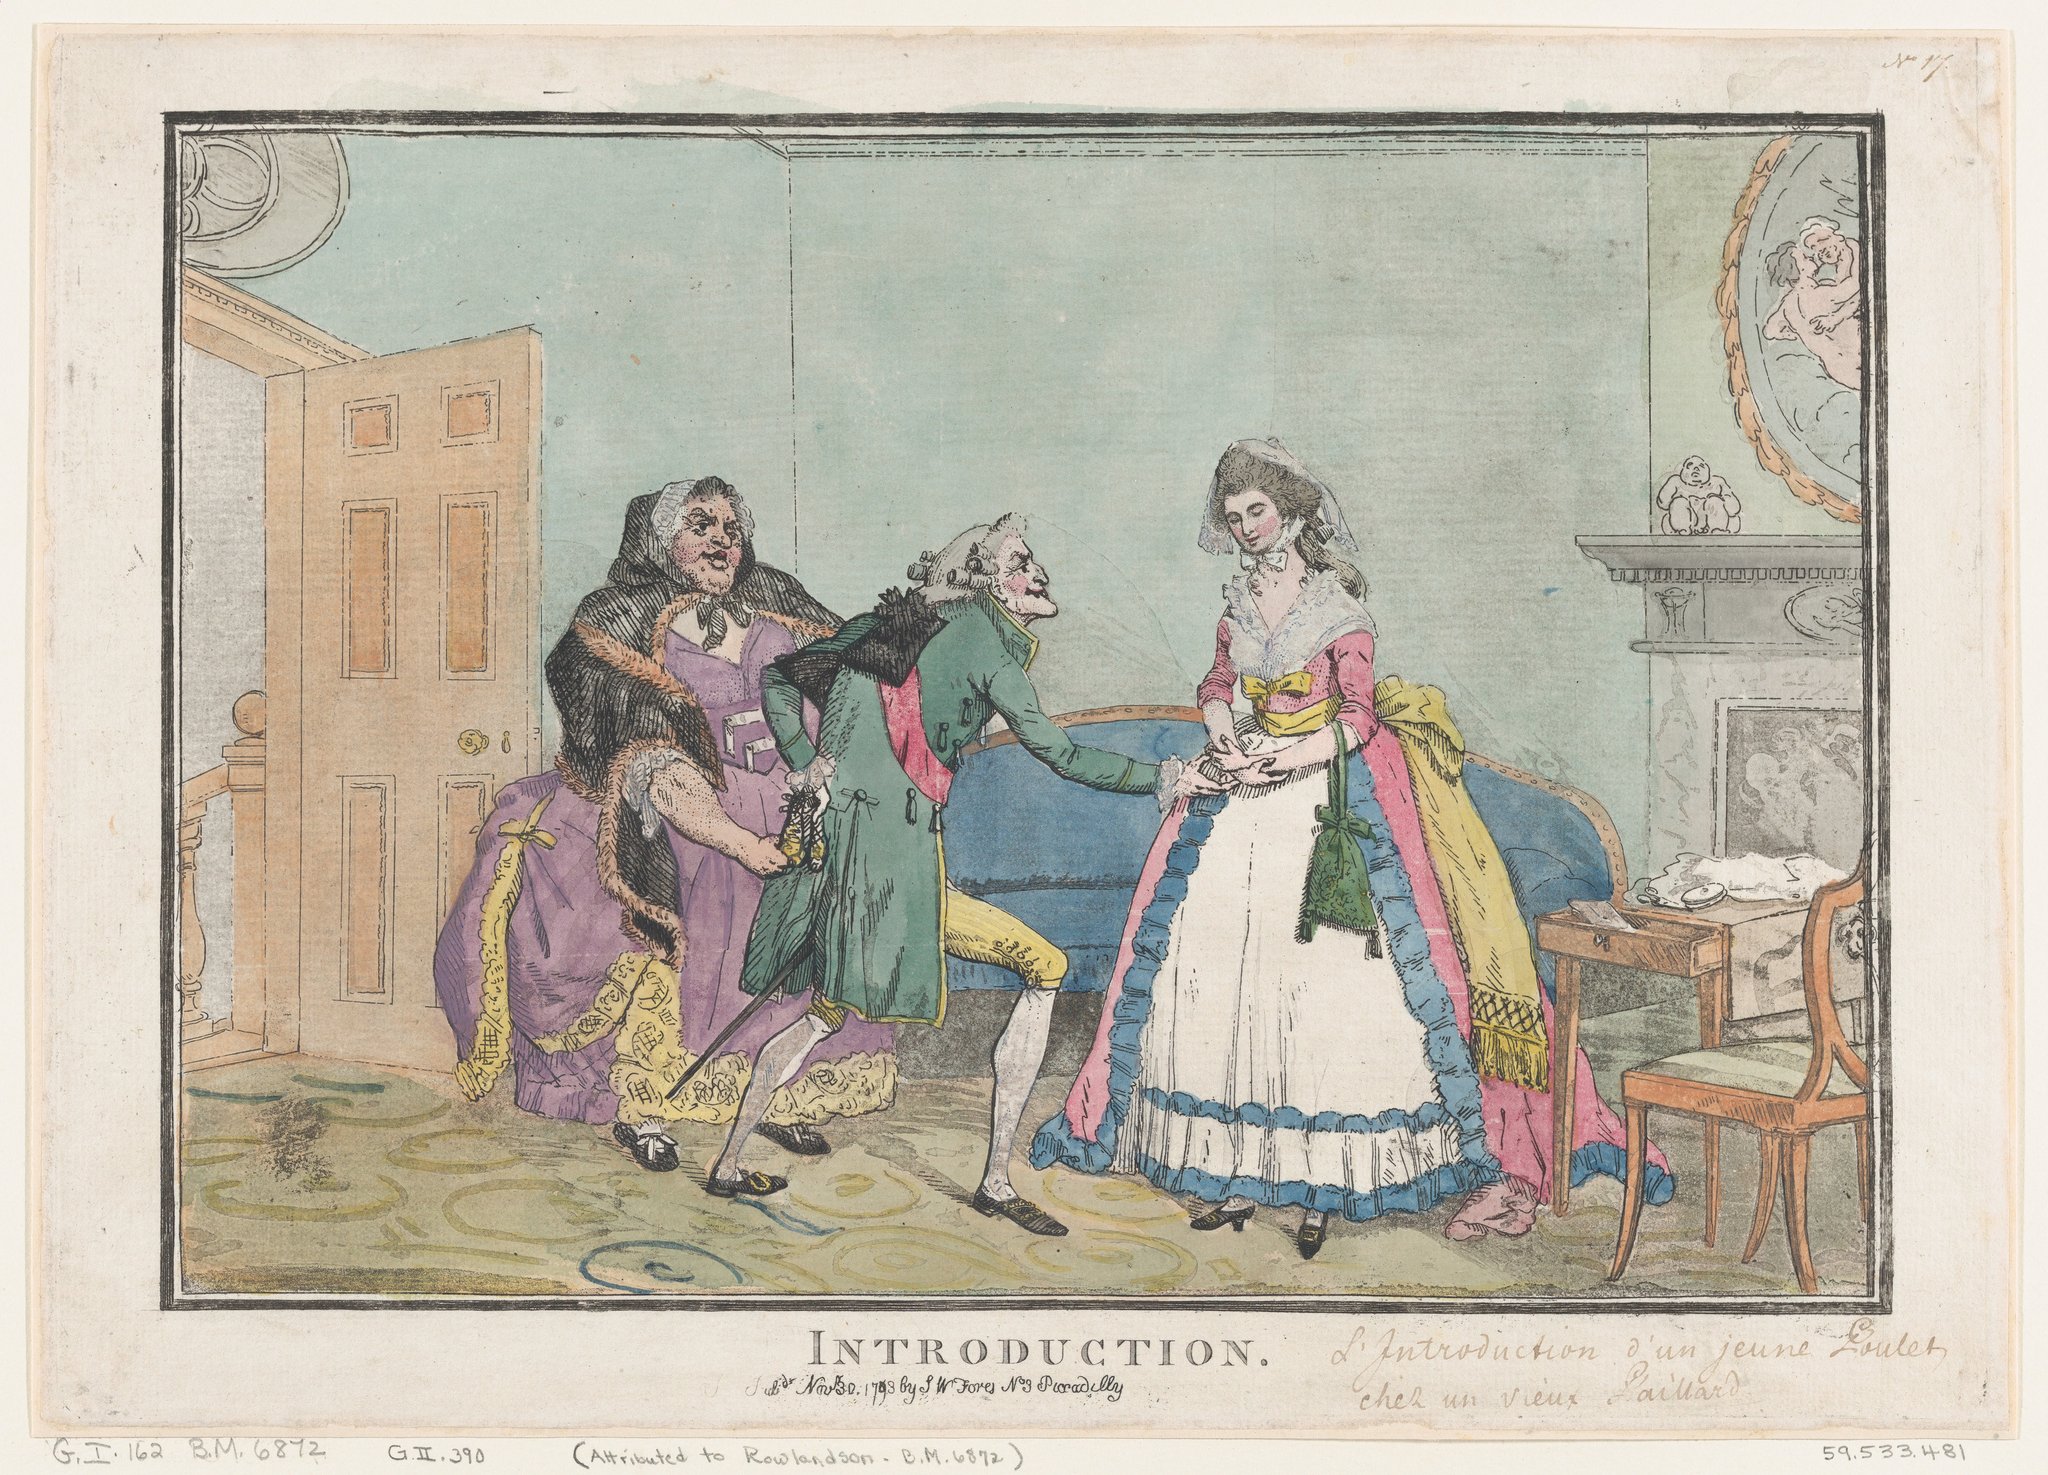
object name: print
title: Introduction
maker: thomas rowlandson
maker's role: artist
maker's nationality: british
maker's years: 1757-1827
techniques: etching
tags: men,women